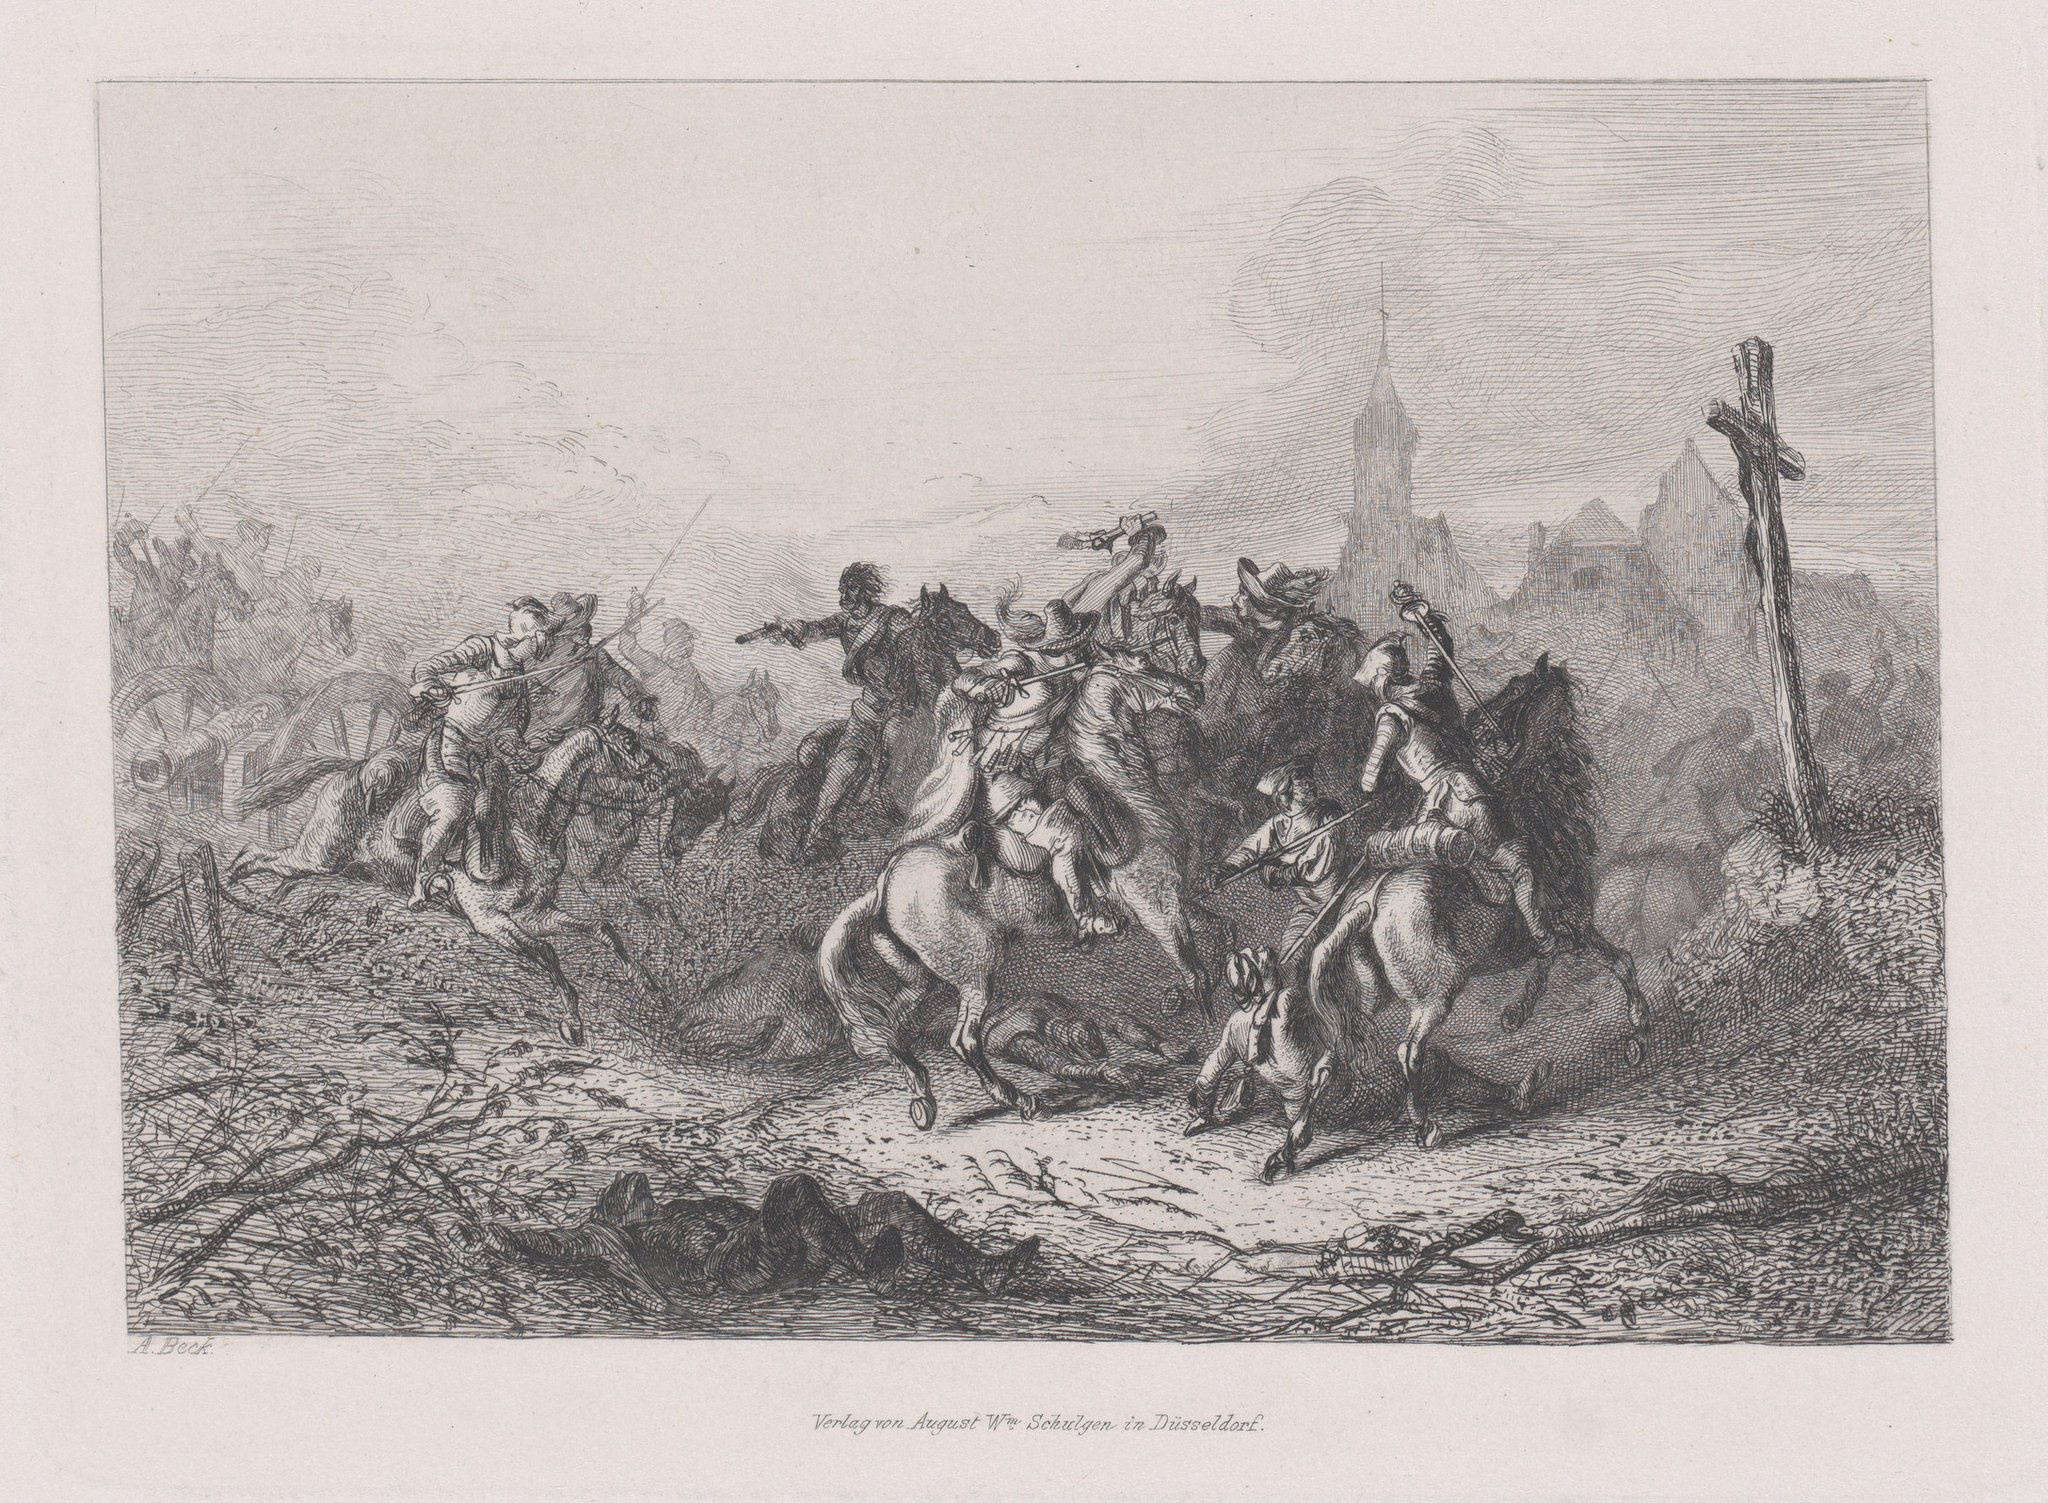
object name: print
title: Military scene with a cross at right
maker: august beck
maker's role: artist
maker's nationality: swiss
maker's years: 1823-1872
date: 1840-1860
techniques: etching